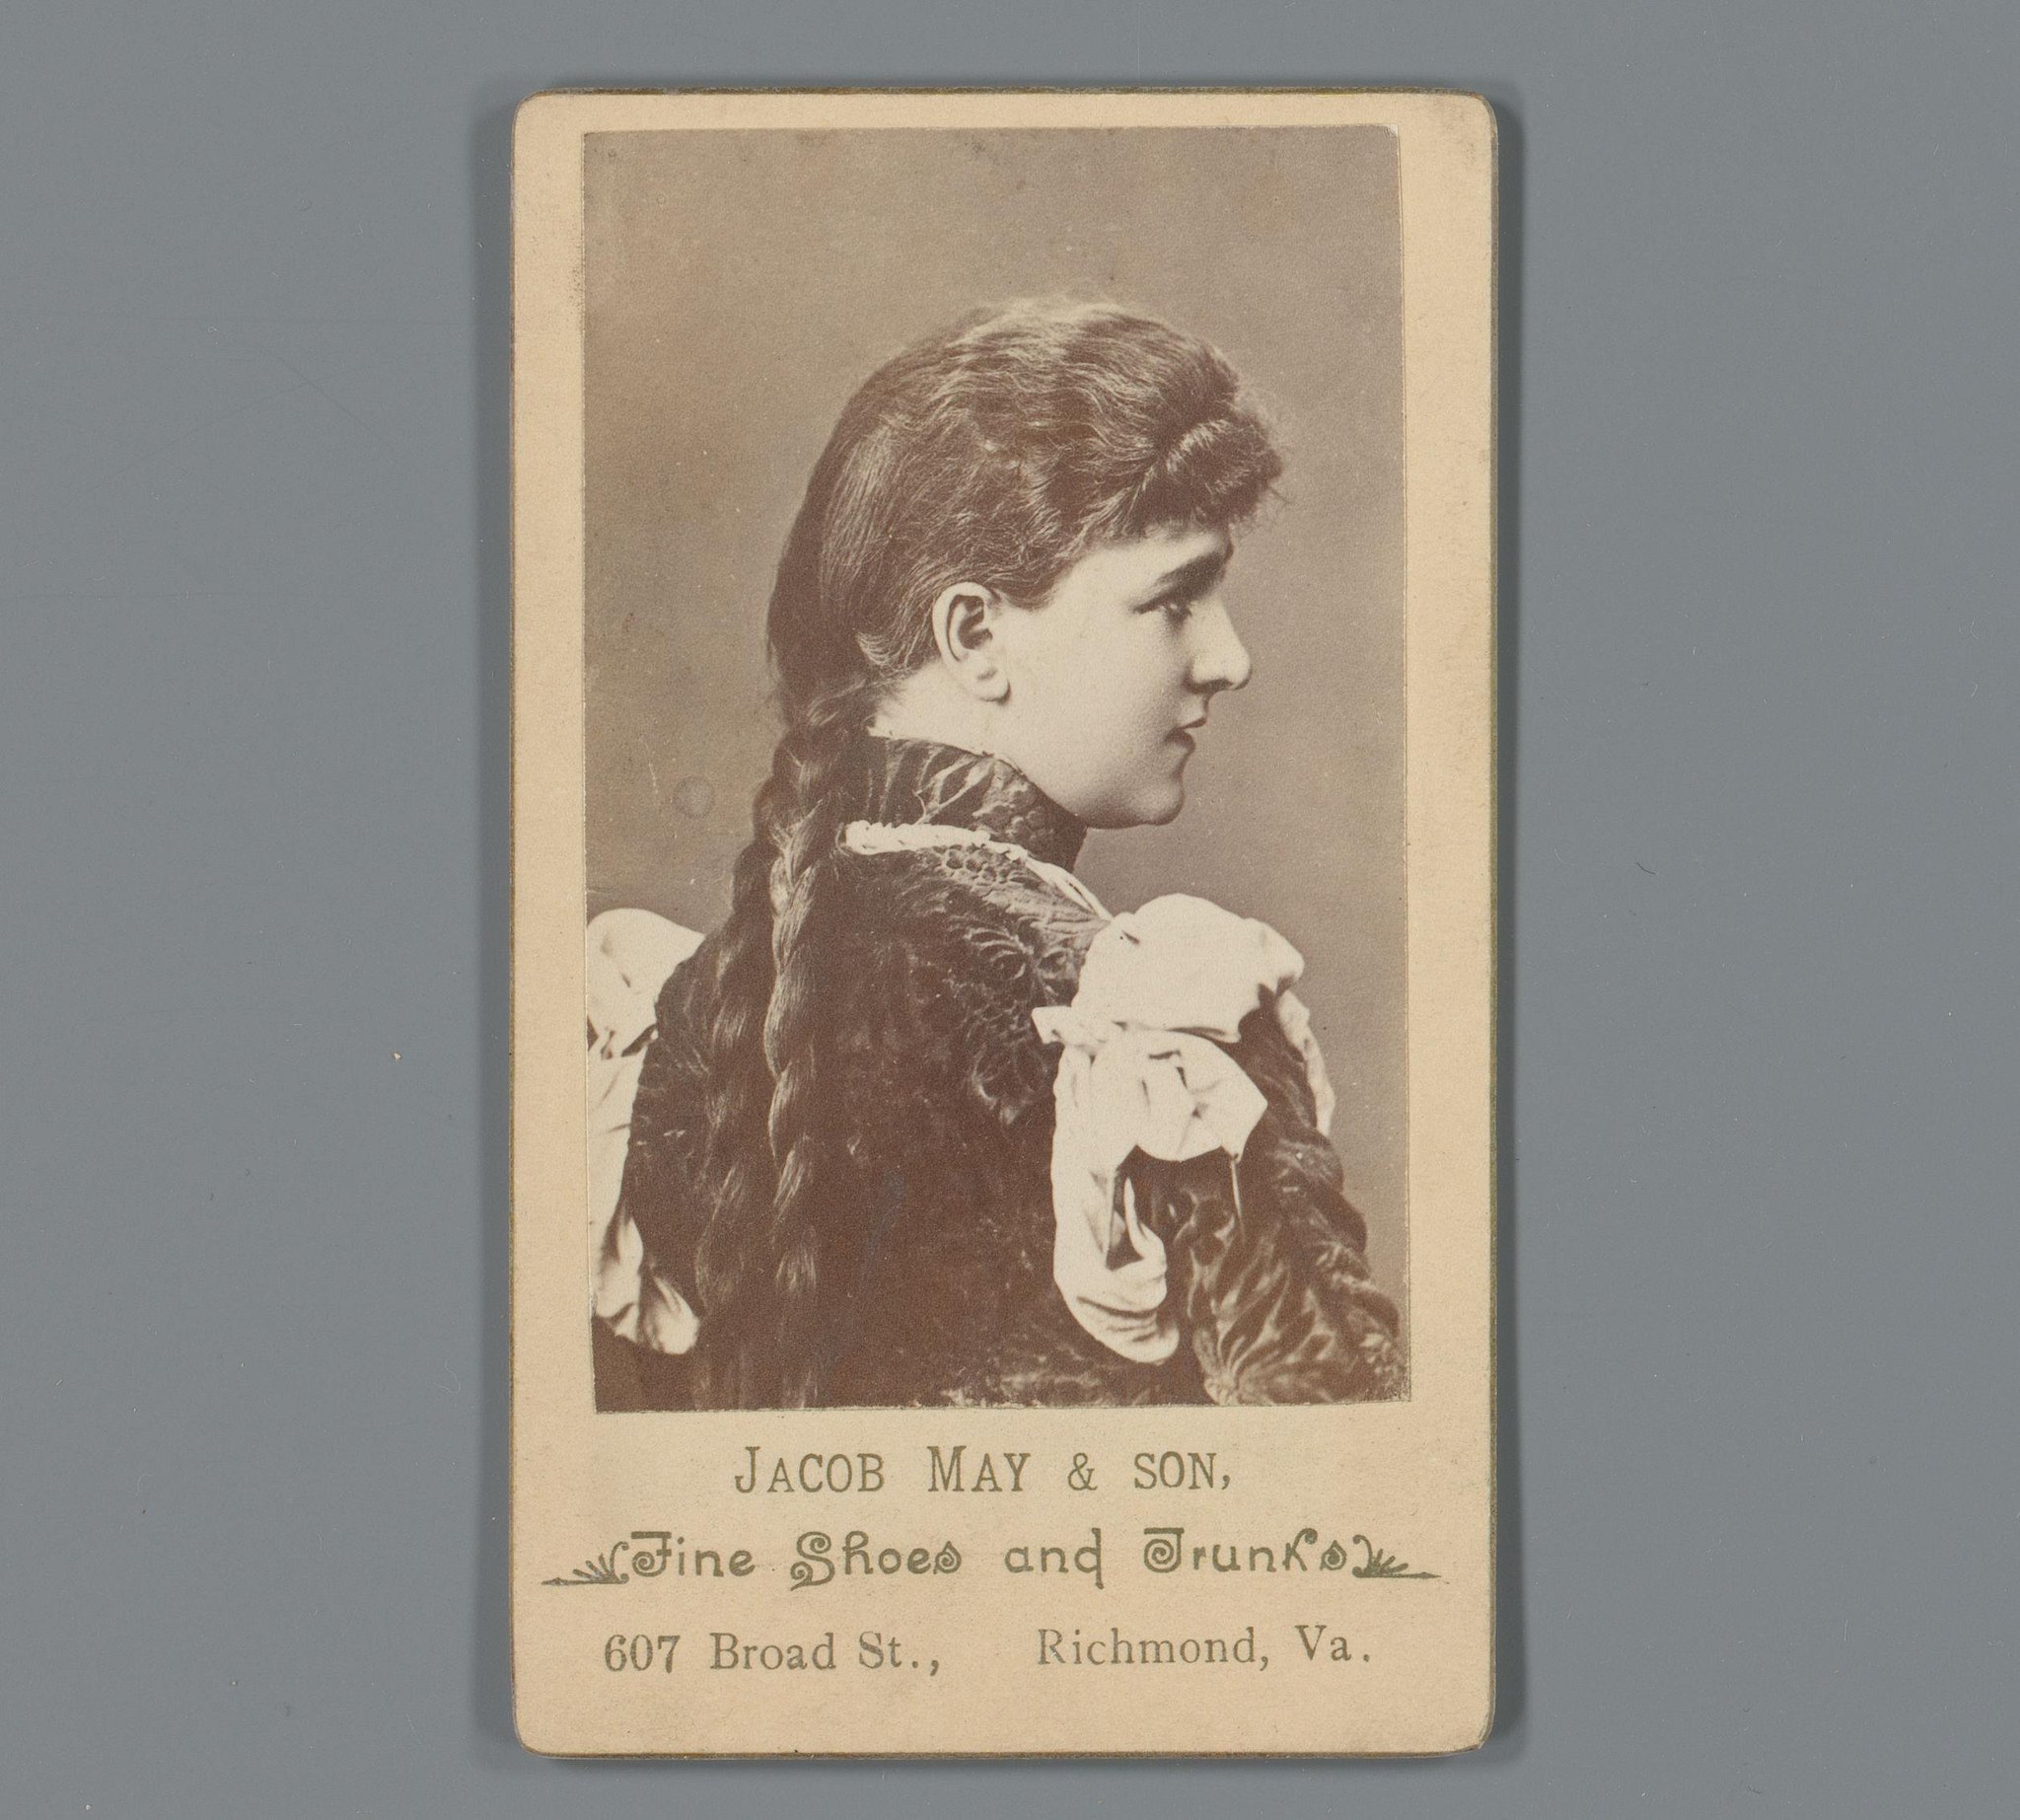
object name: carte de visite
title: Jacob May & Son, fine shoes and trunks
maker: Anonymous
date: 1850-1915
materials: cardboard, photographic support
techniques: albumen print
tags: advertising, historical persons not known by name - bb - woman